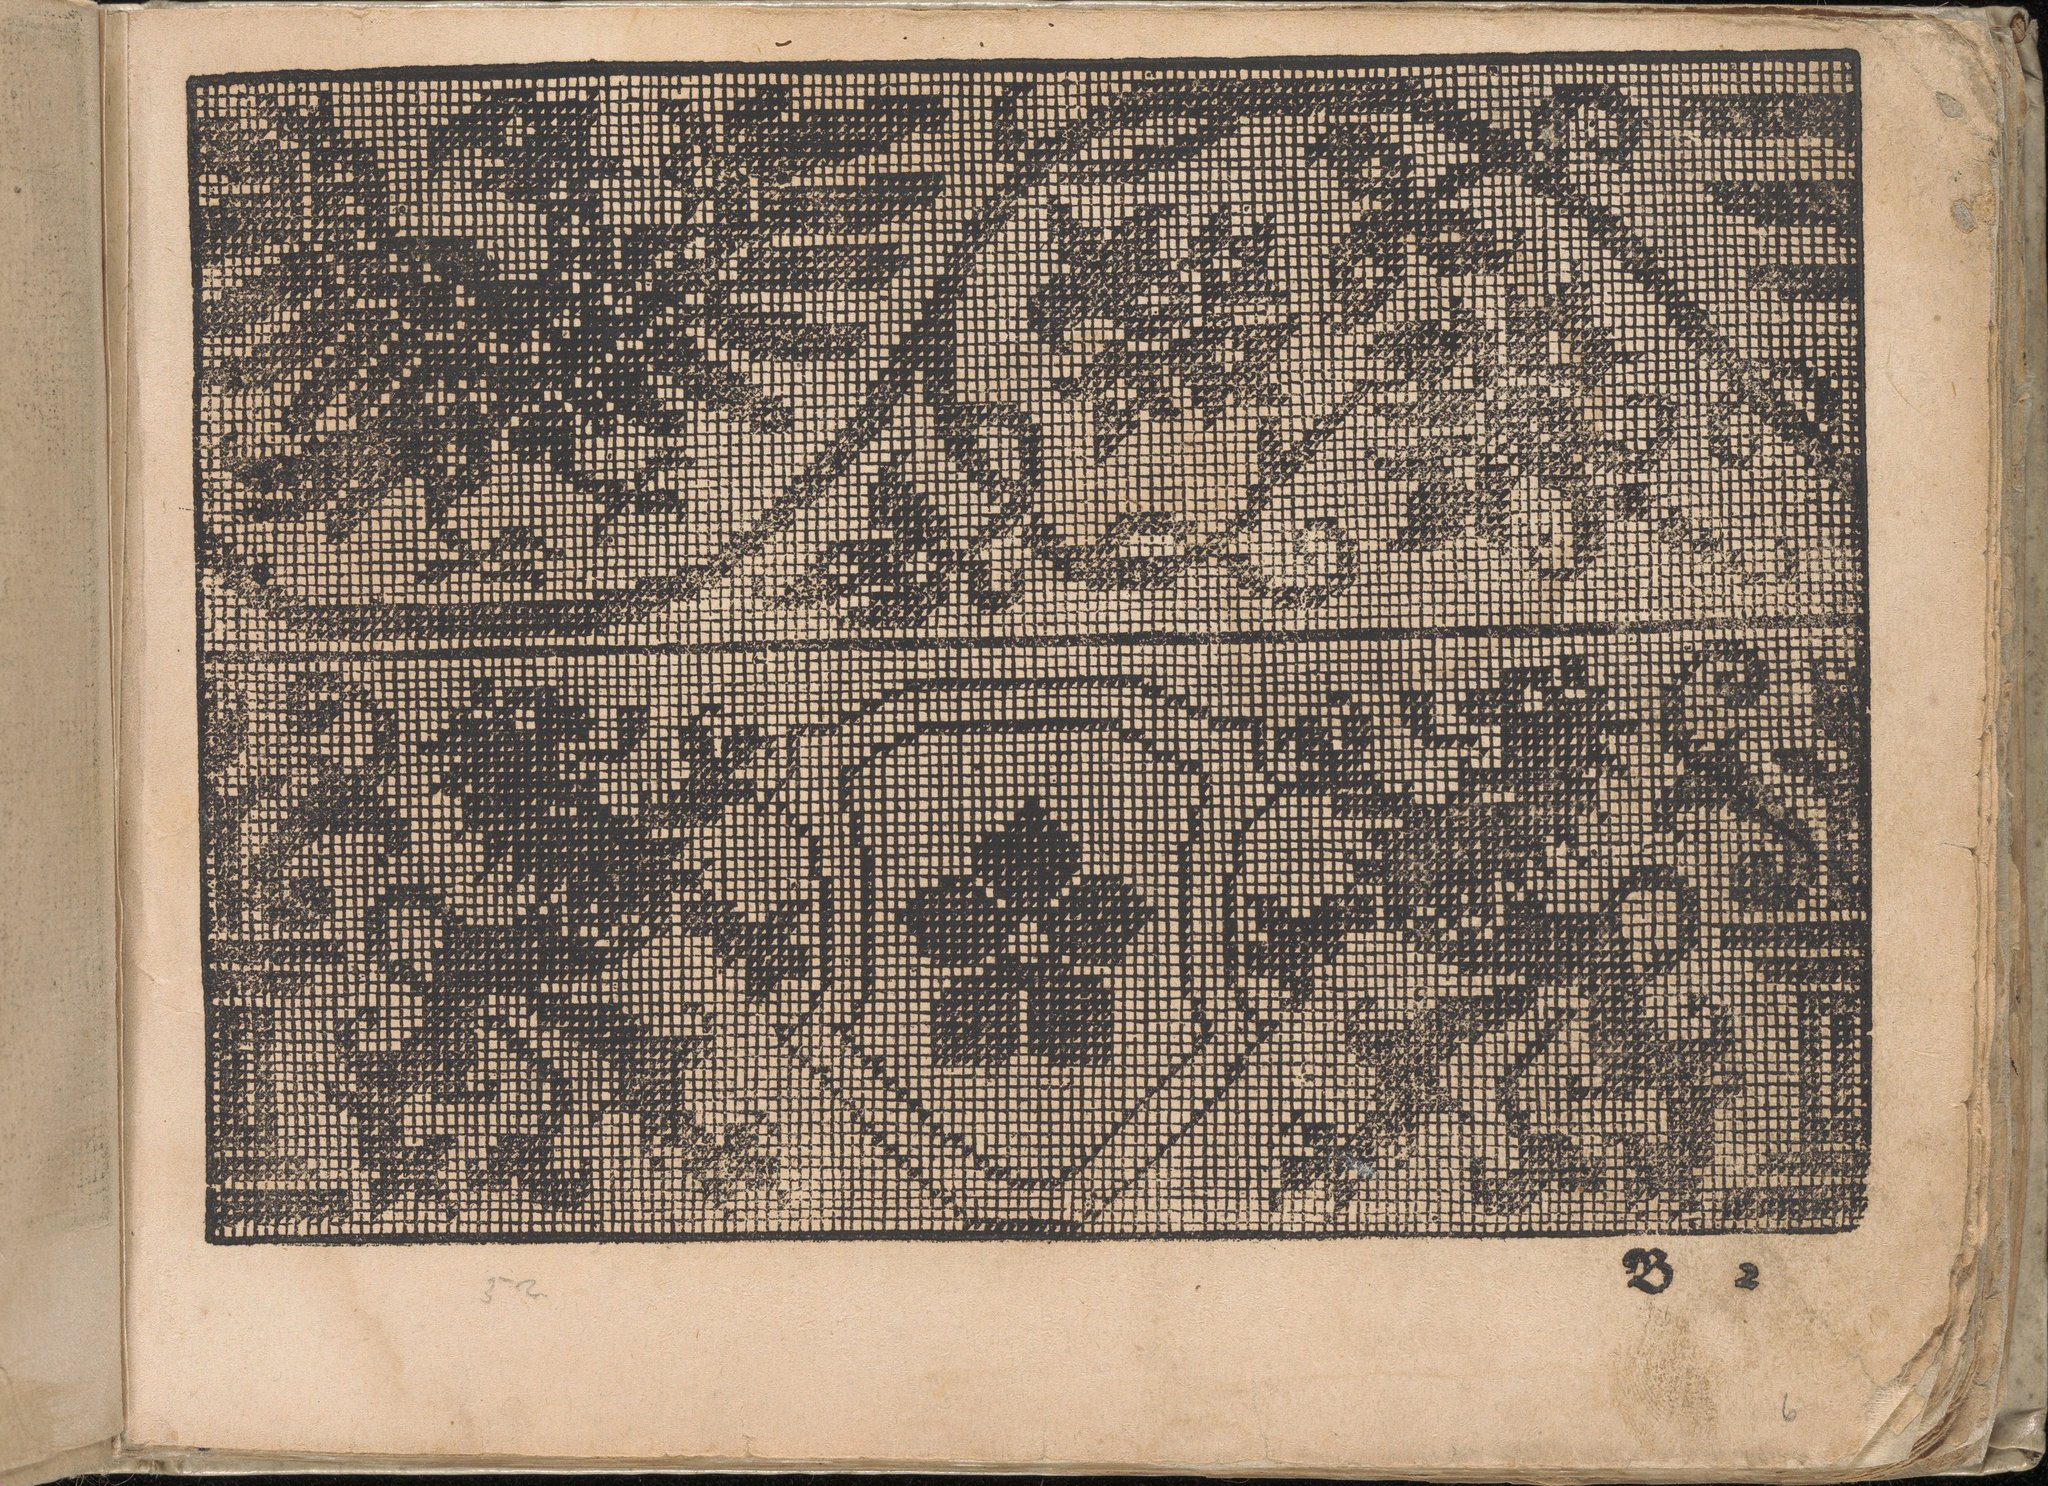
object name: book print ornament architecture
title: Neu künstlich Modelbuch (page 6r)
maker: bernhard jobin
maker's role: publisher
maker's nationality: swiss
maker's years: 1535-1597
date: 1598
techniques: woodcut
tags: ornament,griffins